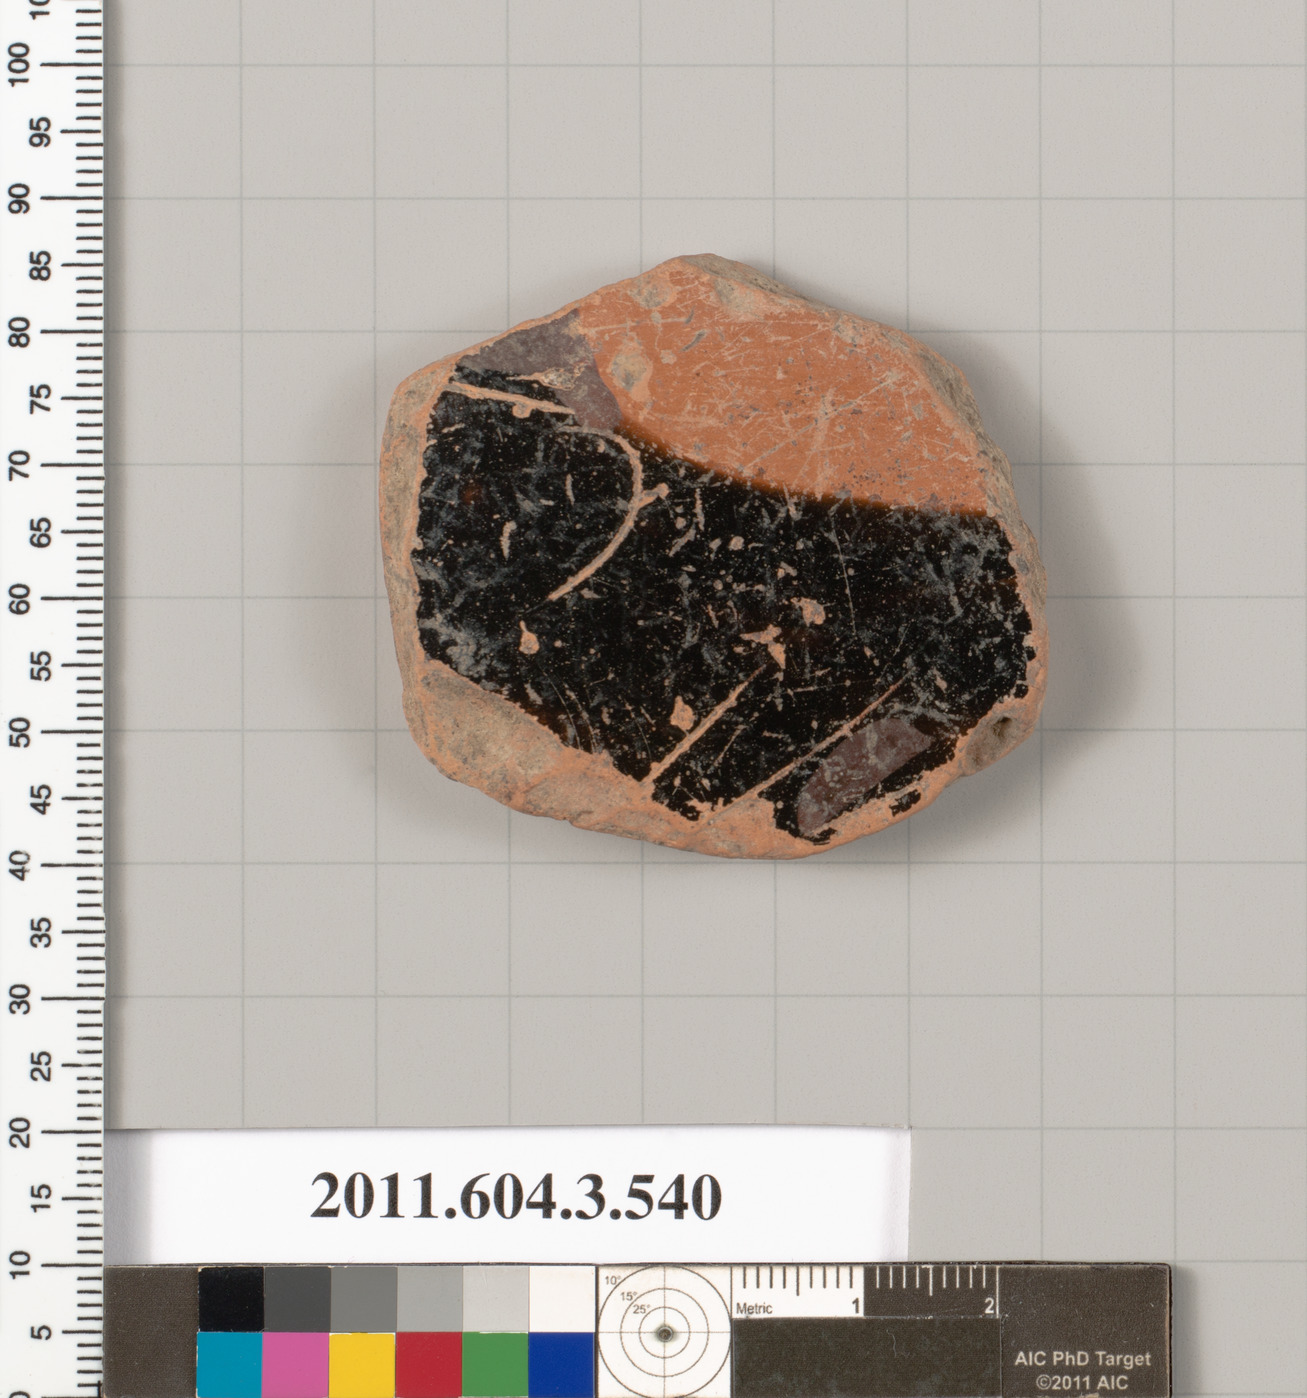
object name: column krater fragment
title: Terracotta fragment of a column-krater (bowl for mixing wine and water)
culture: greek, attic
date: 534-468 BCE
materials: terracotta